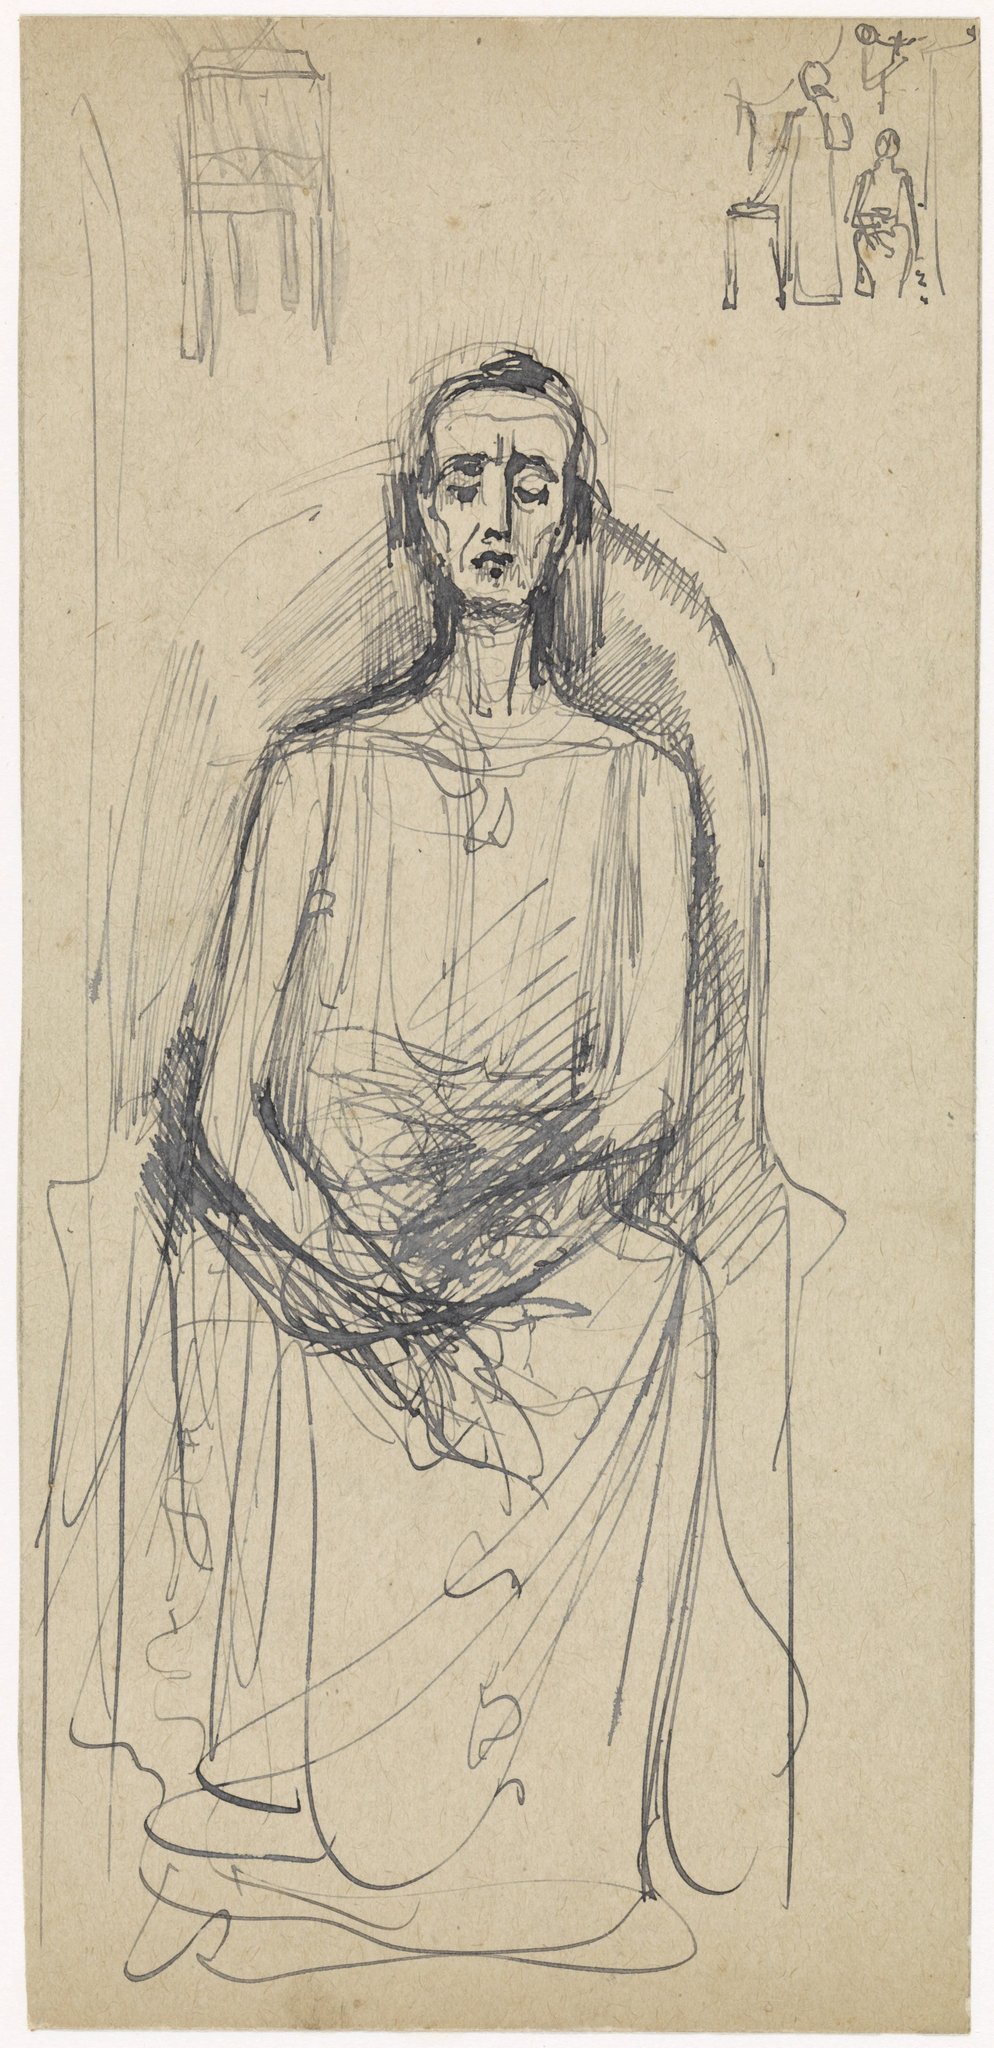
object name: drawing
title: Zittende figuur met neergeslagen ogen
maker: antoon derkinderen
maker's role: draughtsman, painter, print maker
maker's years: 1859-1925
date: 1869-1925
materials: ink, paper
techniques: pen